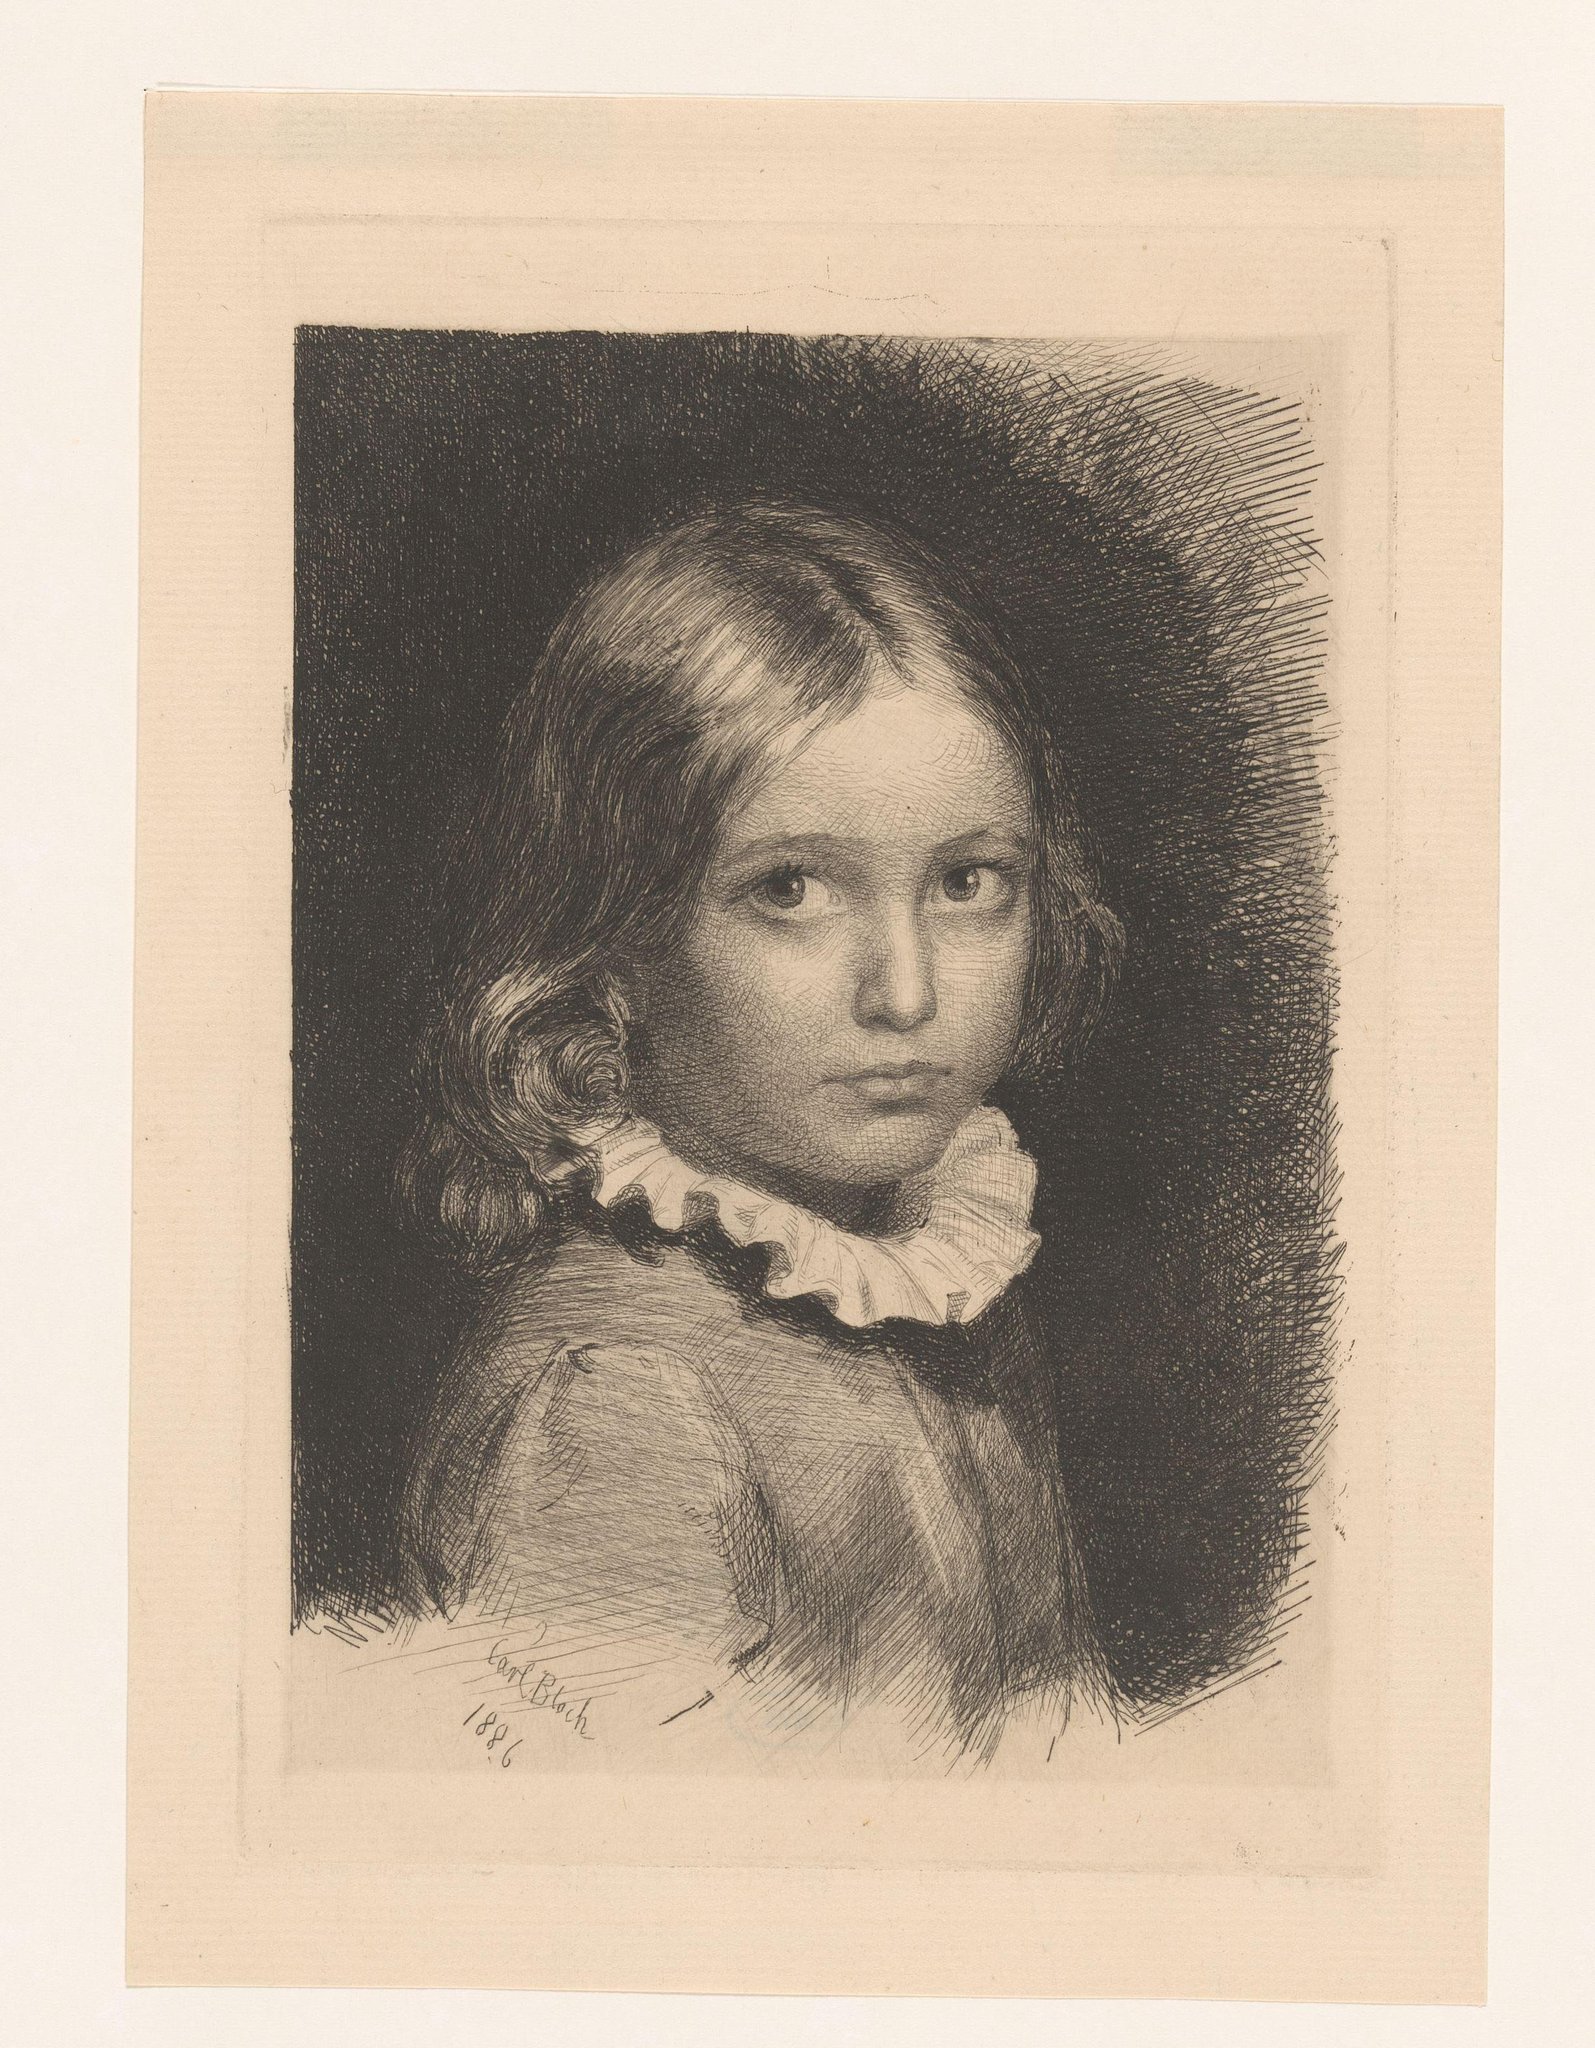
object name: print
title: Buste van een meisje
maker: carl bloch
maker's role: print maker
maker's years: 1834-1890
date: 1886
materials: paper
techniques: etching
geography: denmark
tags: girl (child between toddler and youth), anonymous historical person portrayed - bb - woman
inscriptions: collector's mark: Lugt 2228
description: Buste van een meisje rechtsgewend, het hoofd en face. Zij heeft een geplooid kraagje om, het krullend haar valt op de rug.